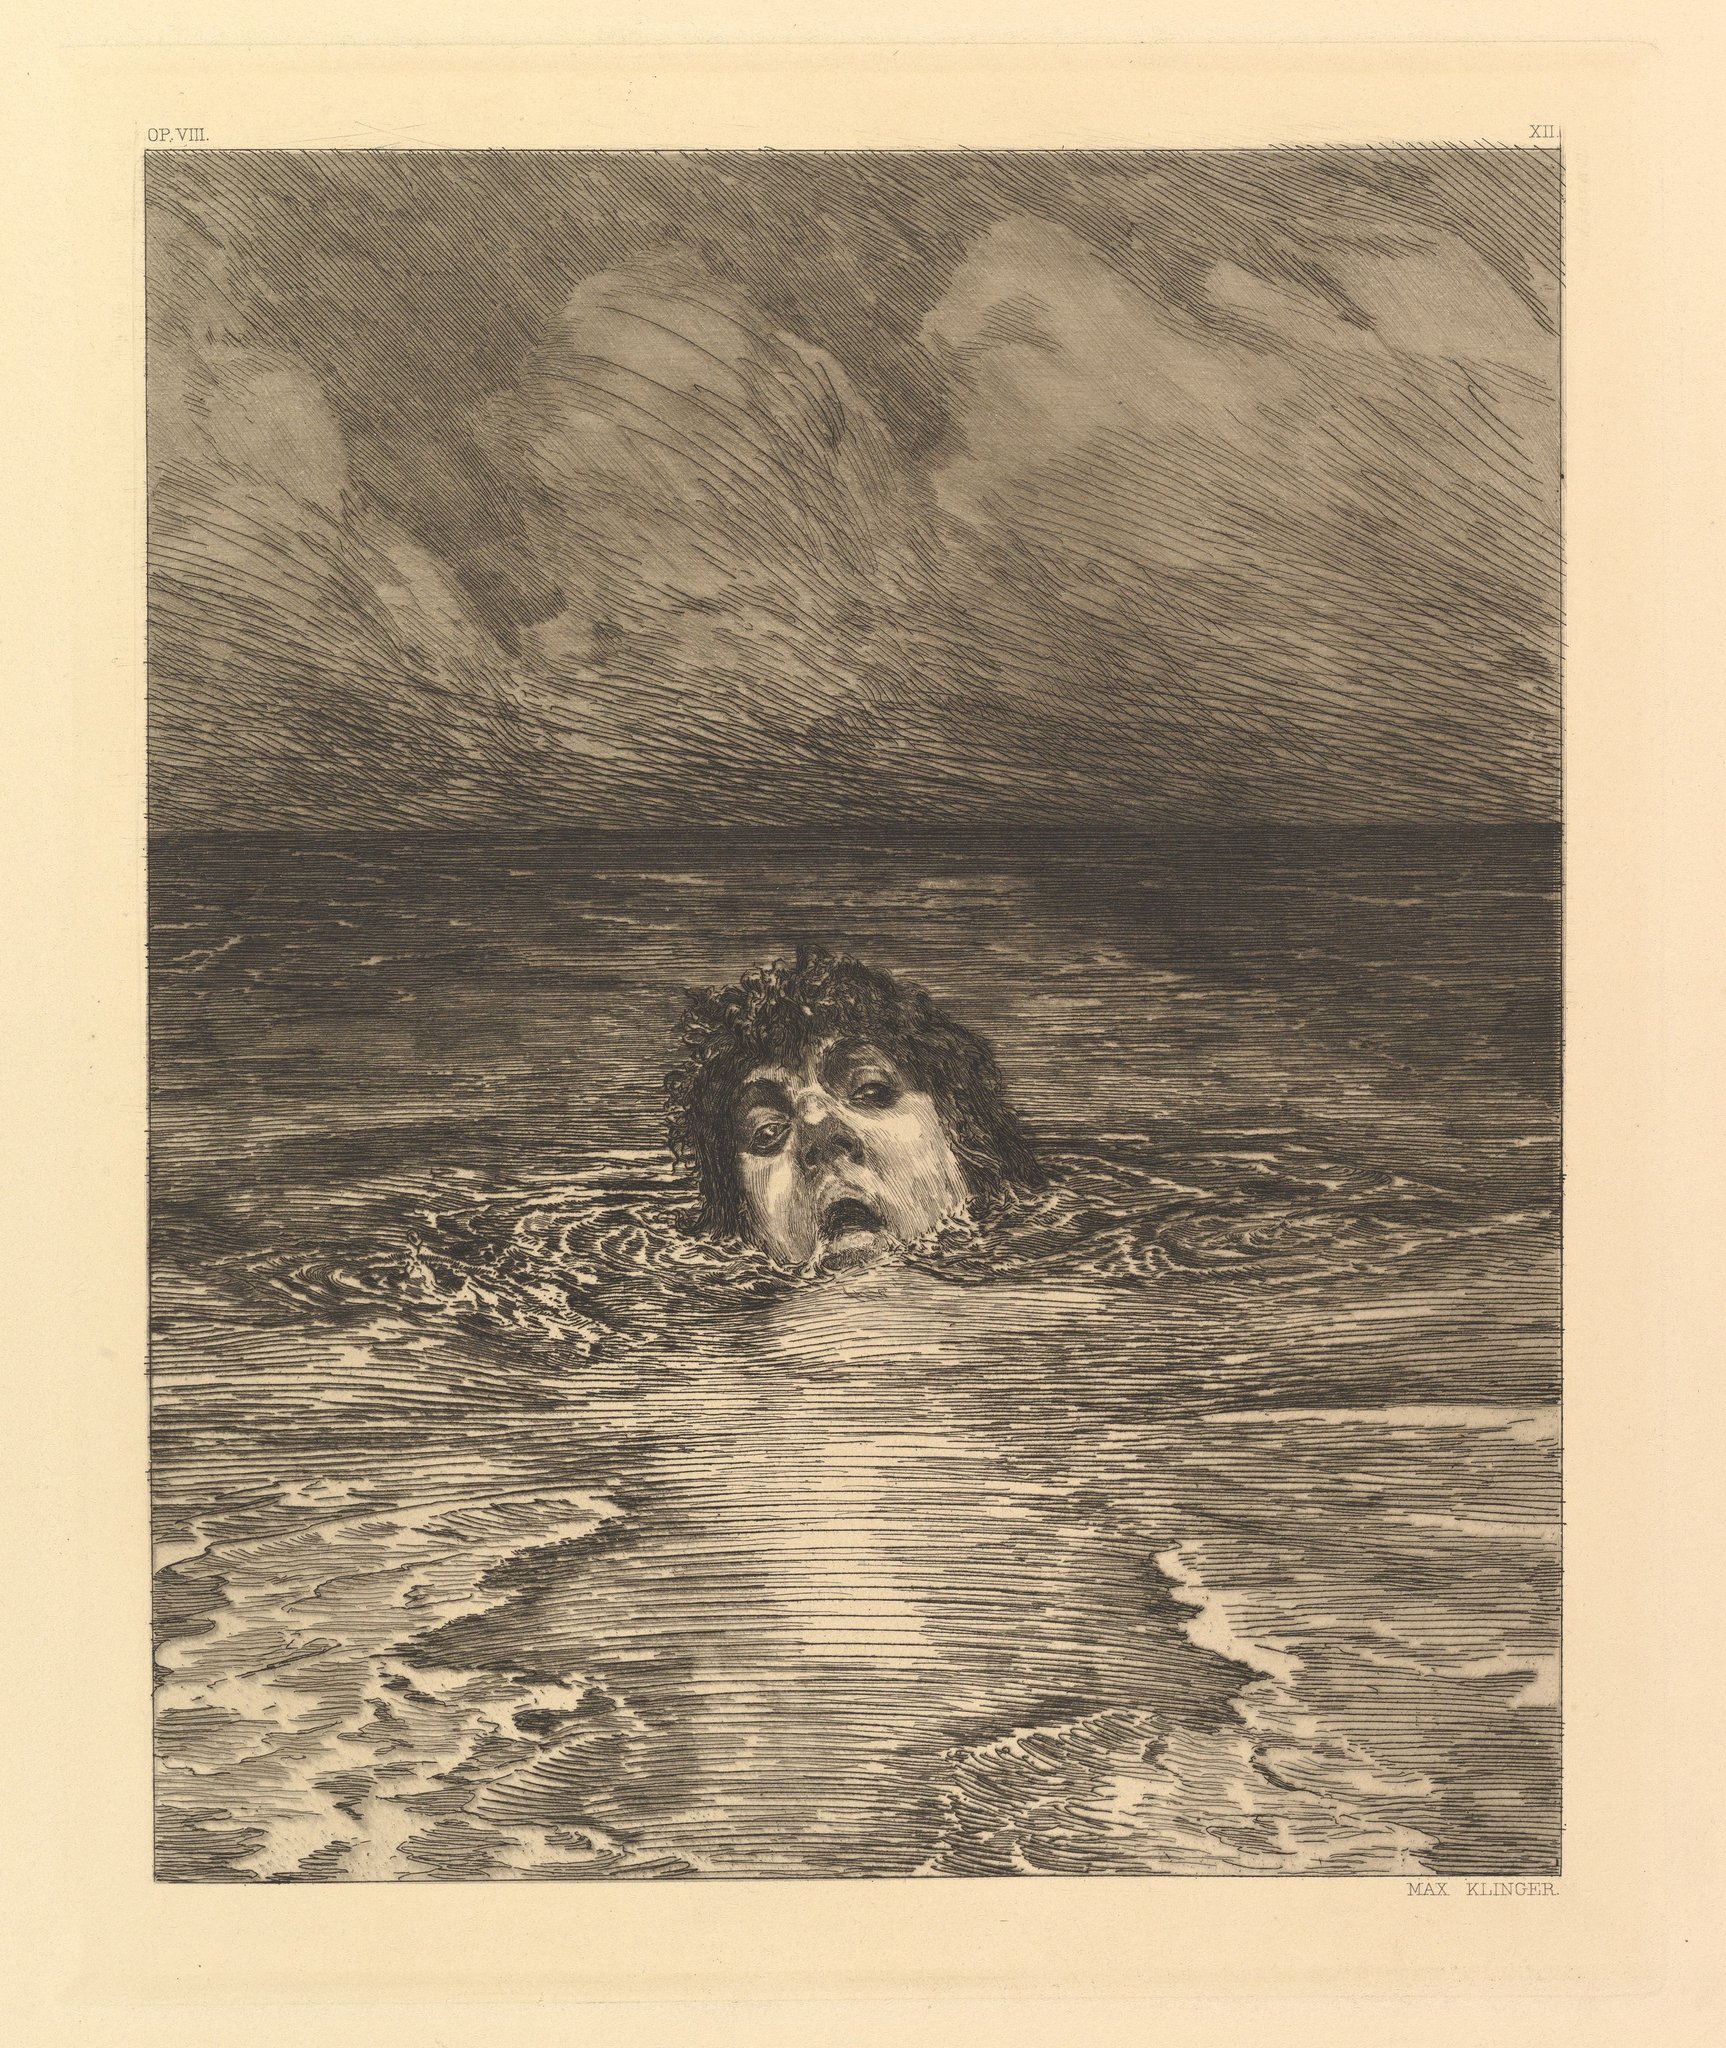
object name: print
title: Going Under (from the series A Life)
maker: max klinger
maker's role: artist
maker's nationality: german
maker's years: 1857-1920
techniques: aquatint, etching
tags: women